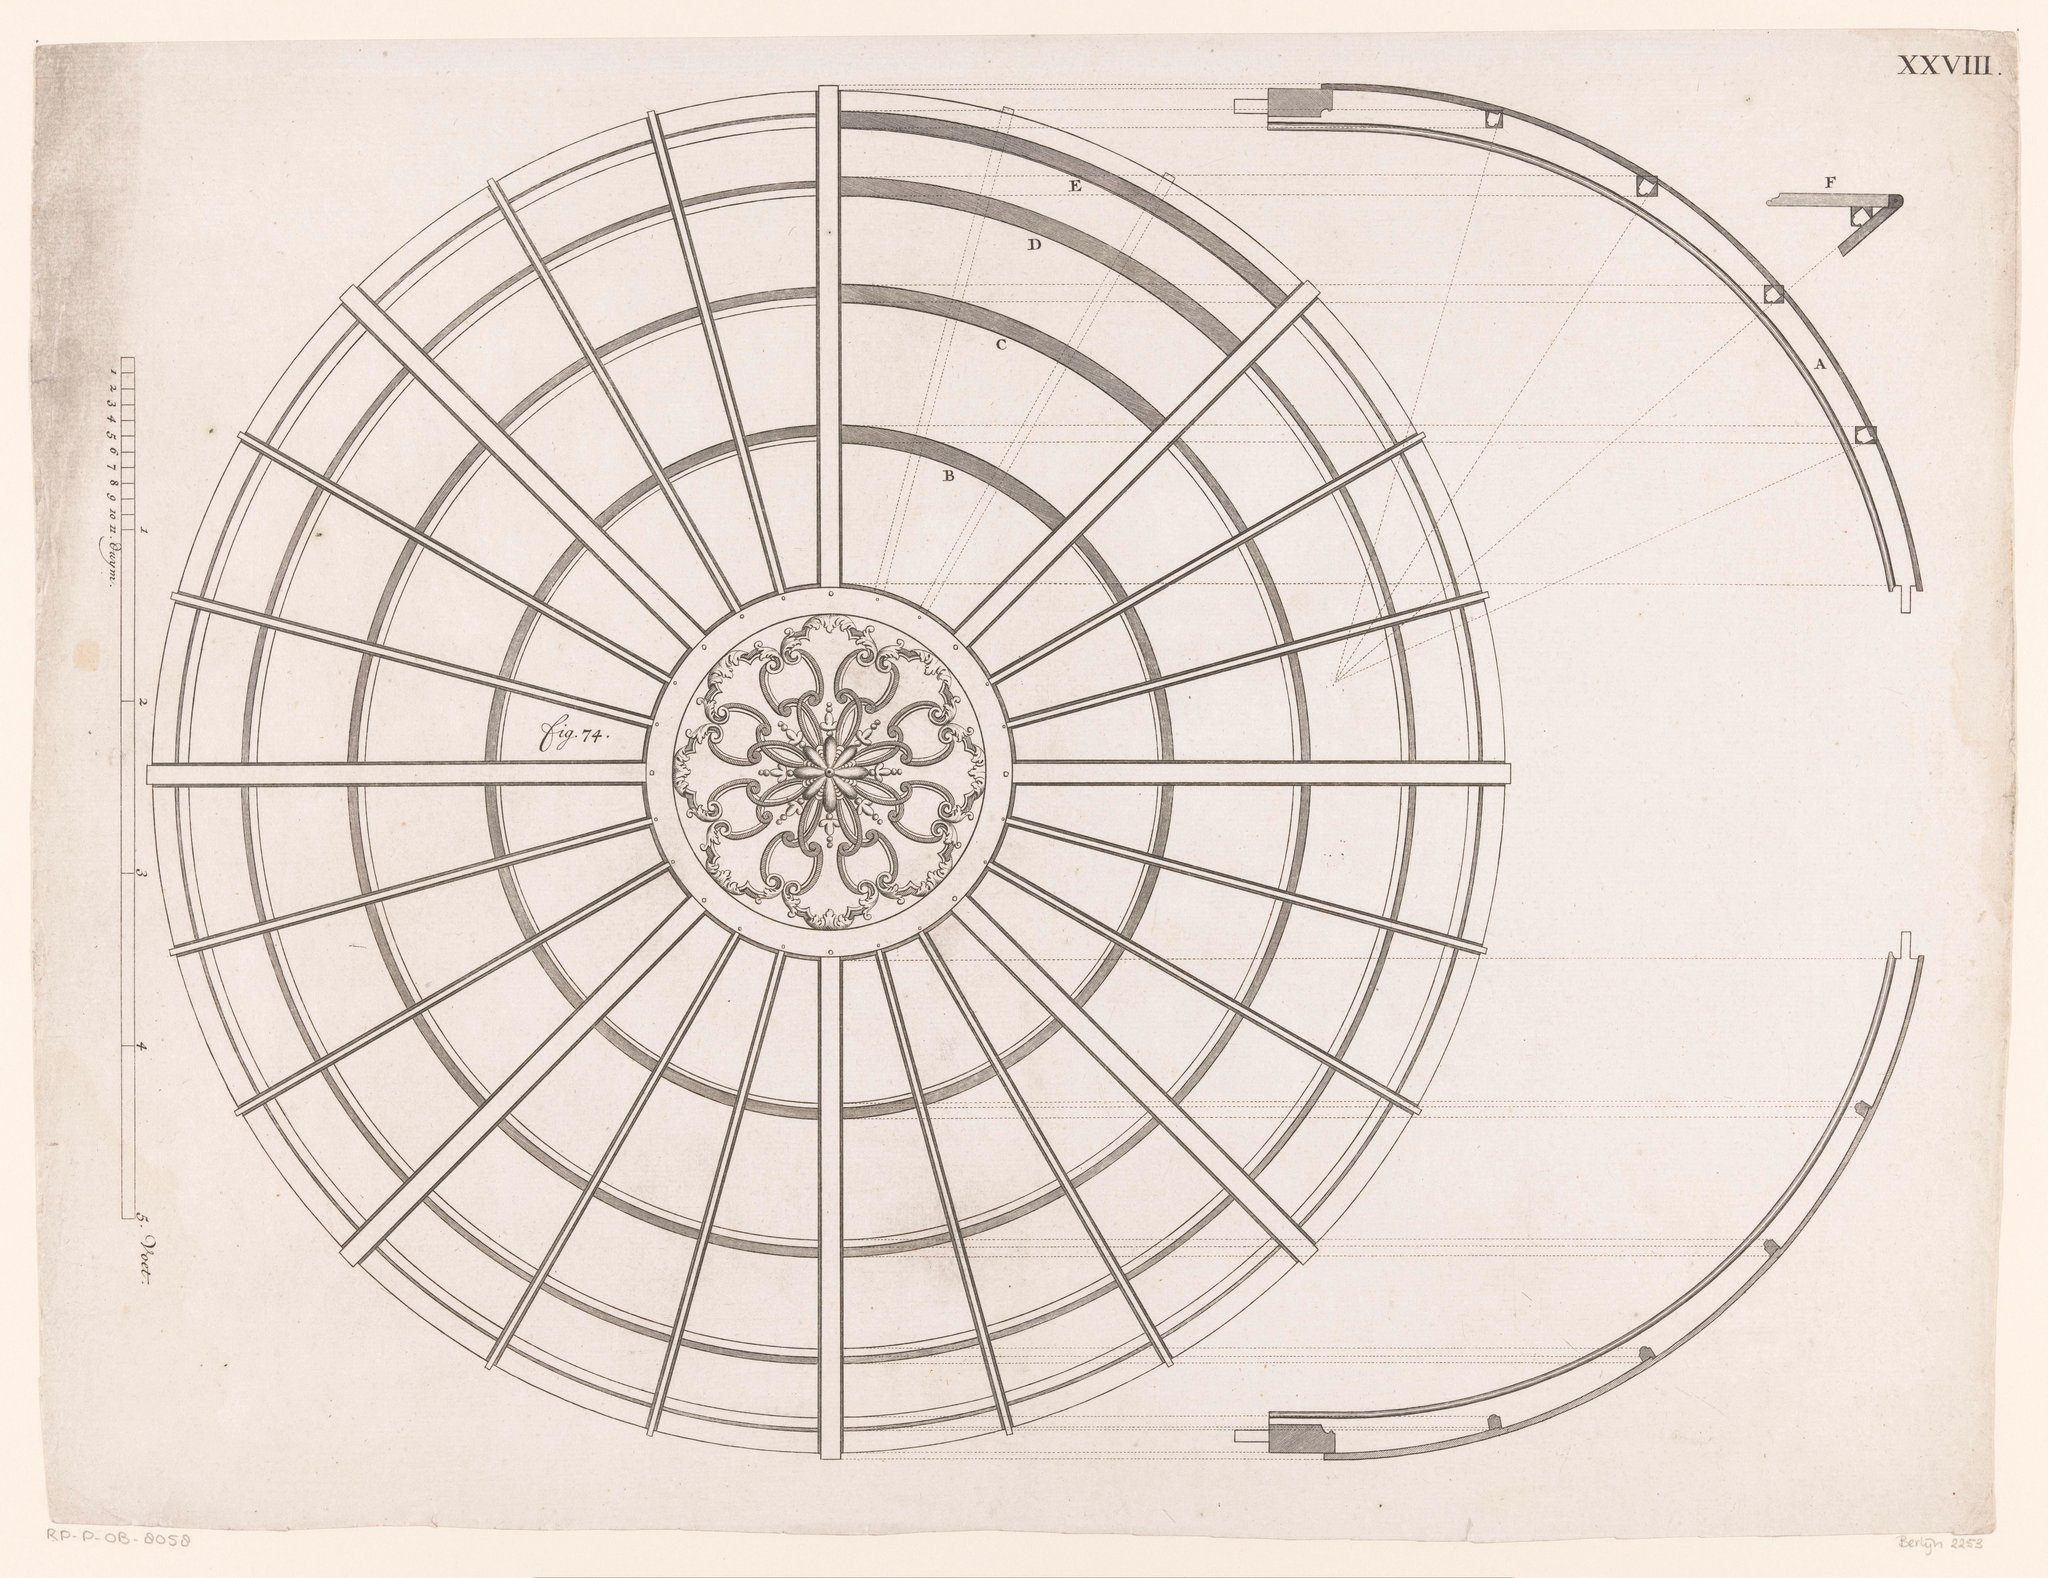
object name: ornament print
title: Technische tekeningen van koepel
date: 1739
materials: paper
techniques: engraving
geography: amsterdam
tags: drawing (mathematics), other architectural details (cupola)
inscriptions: collector's mark: Lugt 2228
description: Technische tekeningen van een geornamenteerde koepel (nummers 74). Bovenaanzicht.